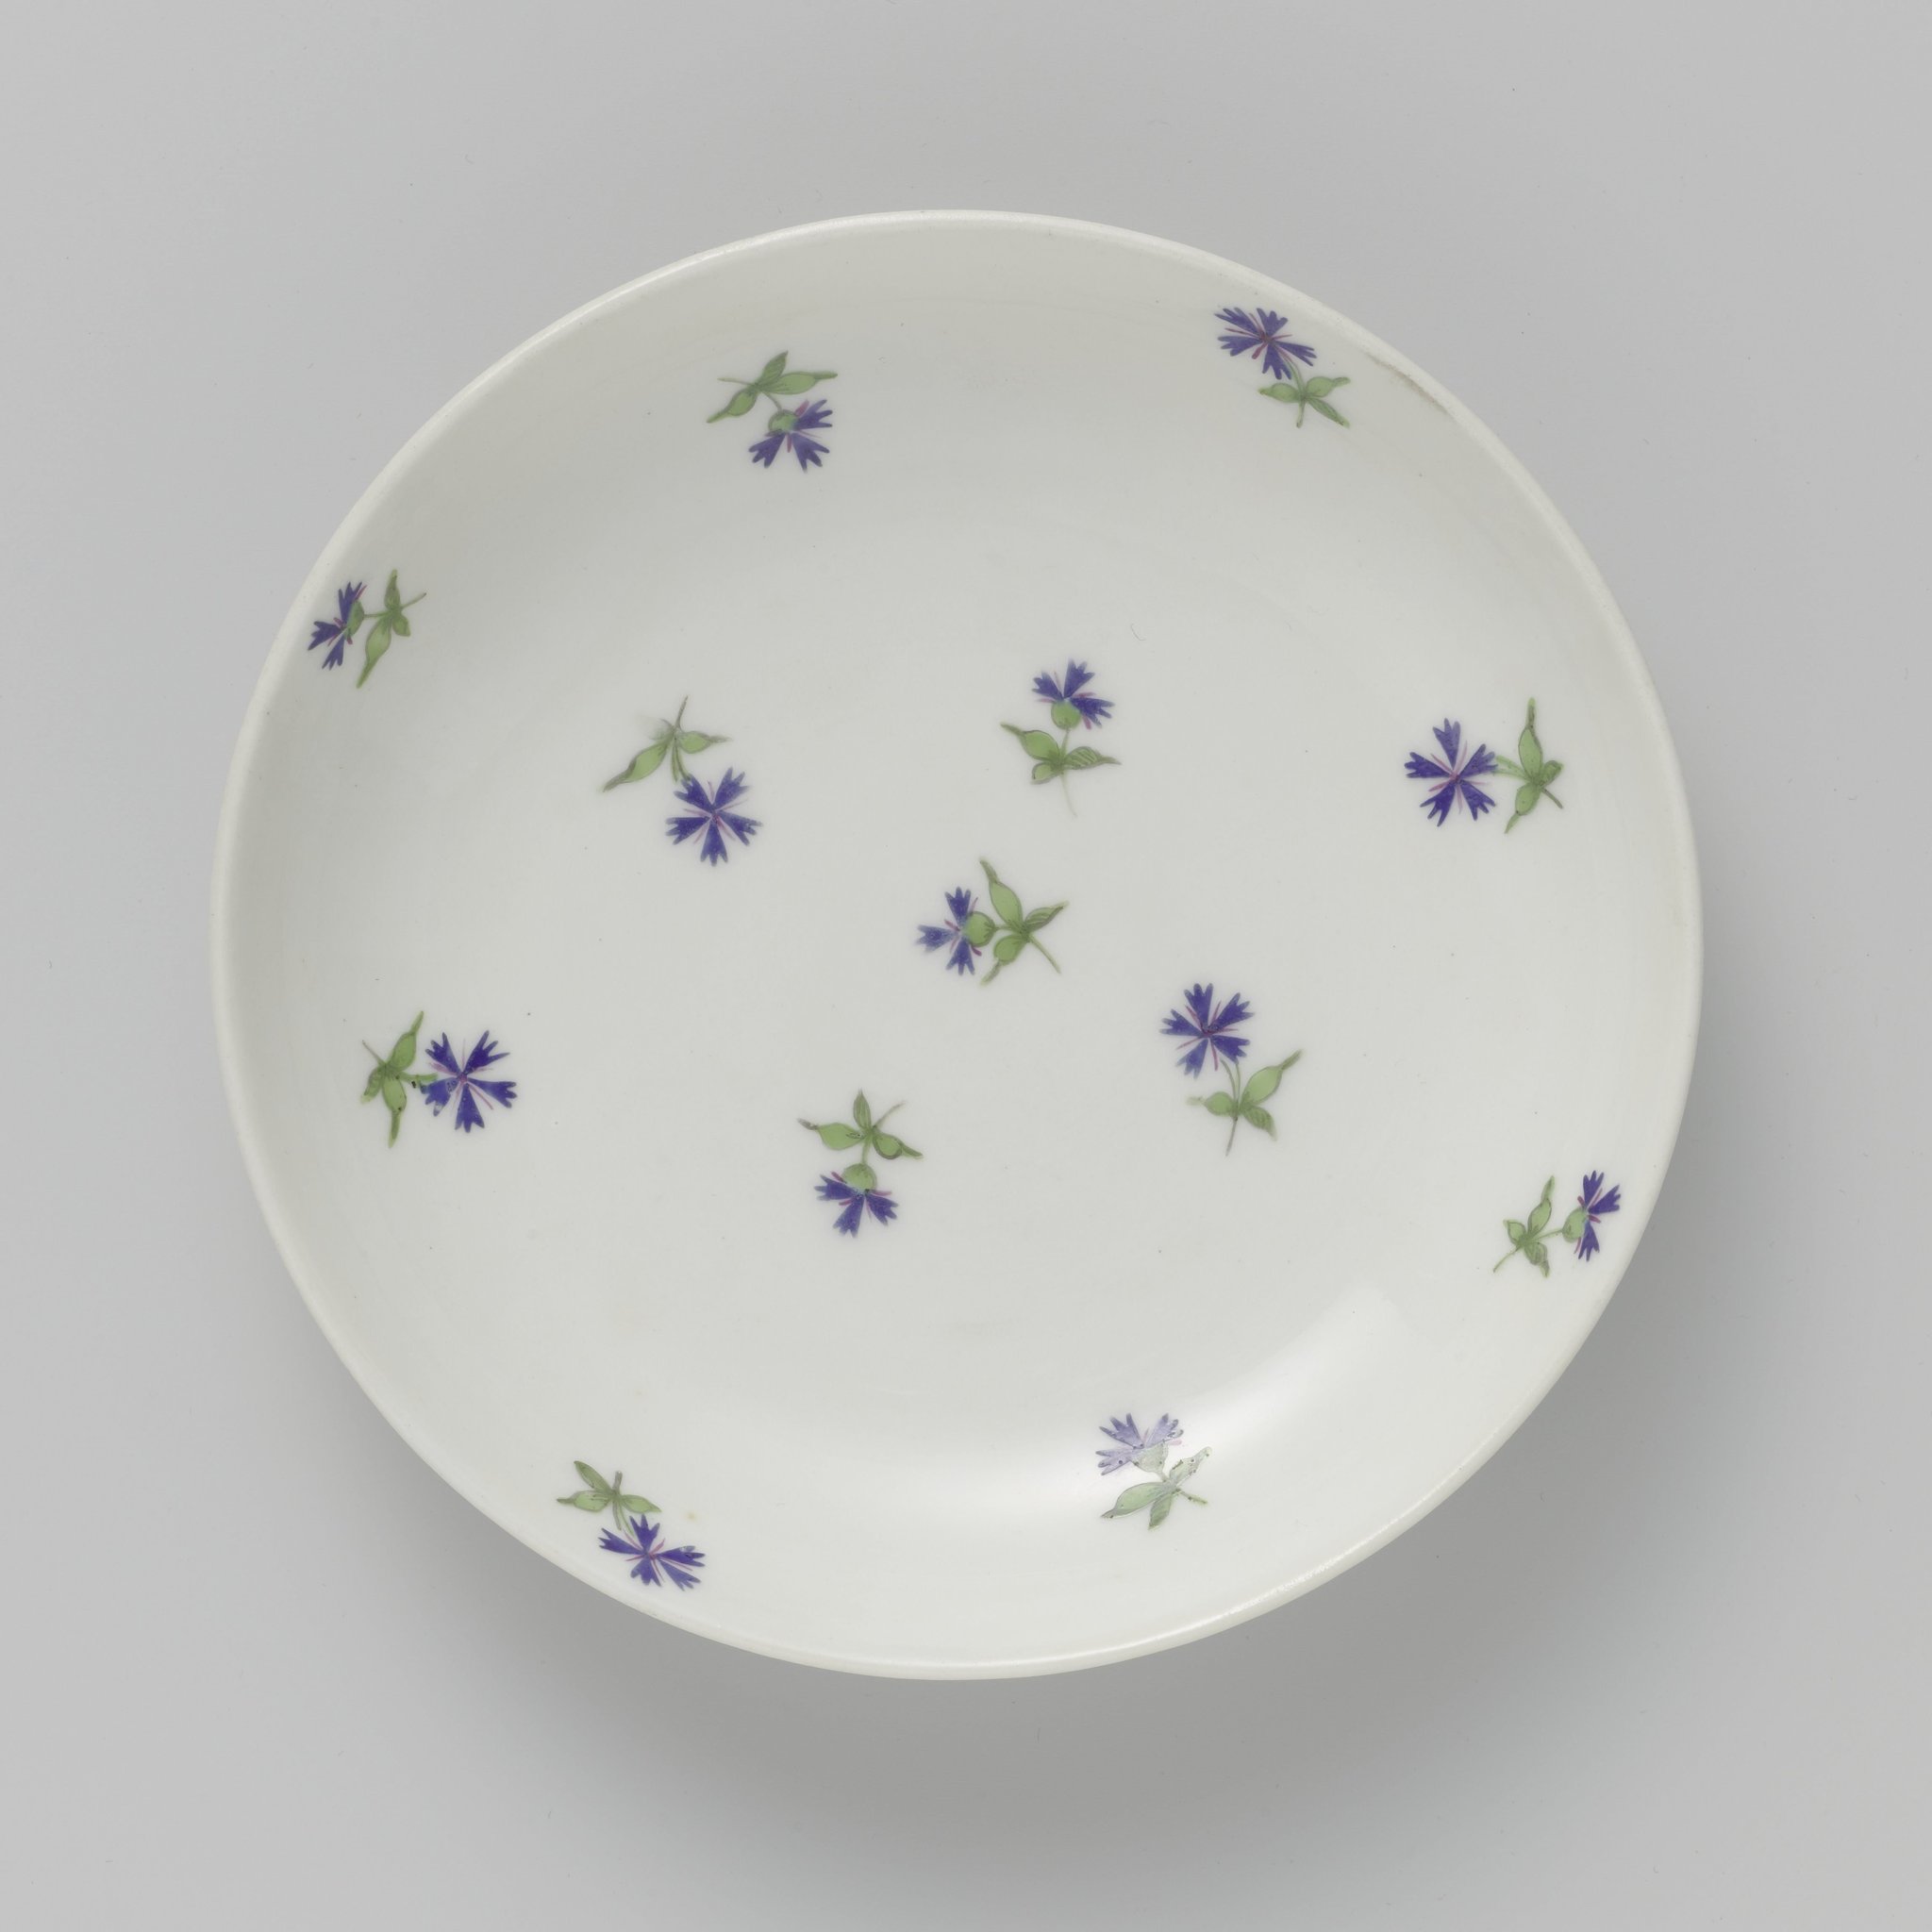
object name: platter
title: Schotel, beschilderd met korenbloemen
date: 1784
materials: porcelain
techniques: painted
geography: loosdrecht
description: Schotel, versierd met korenbloemen. Gemerkt Amstel in blauw onder het glazuur en ingegrift L1.